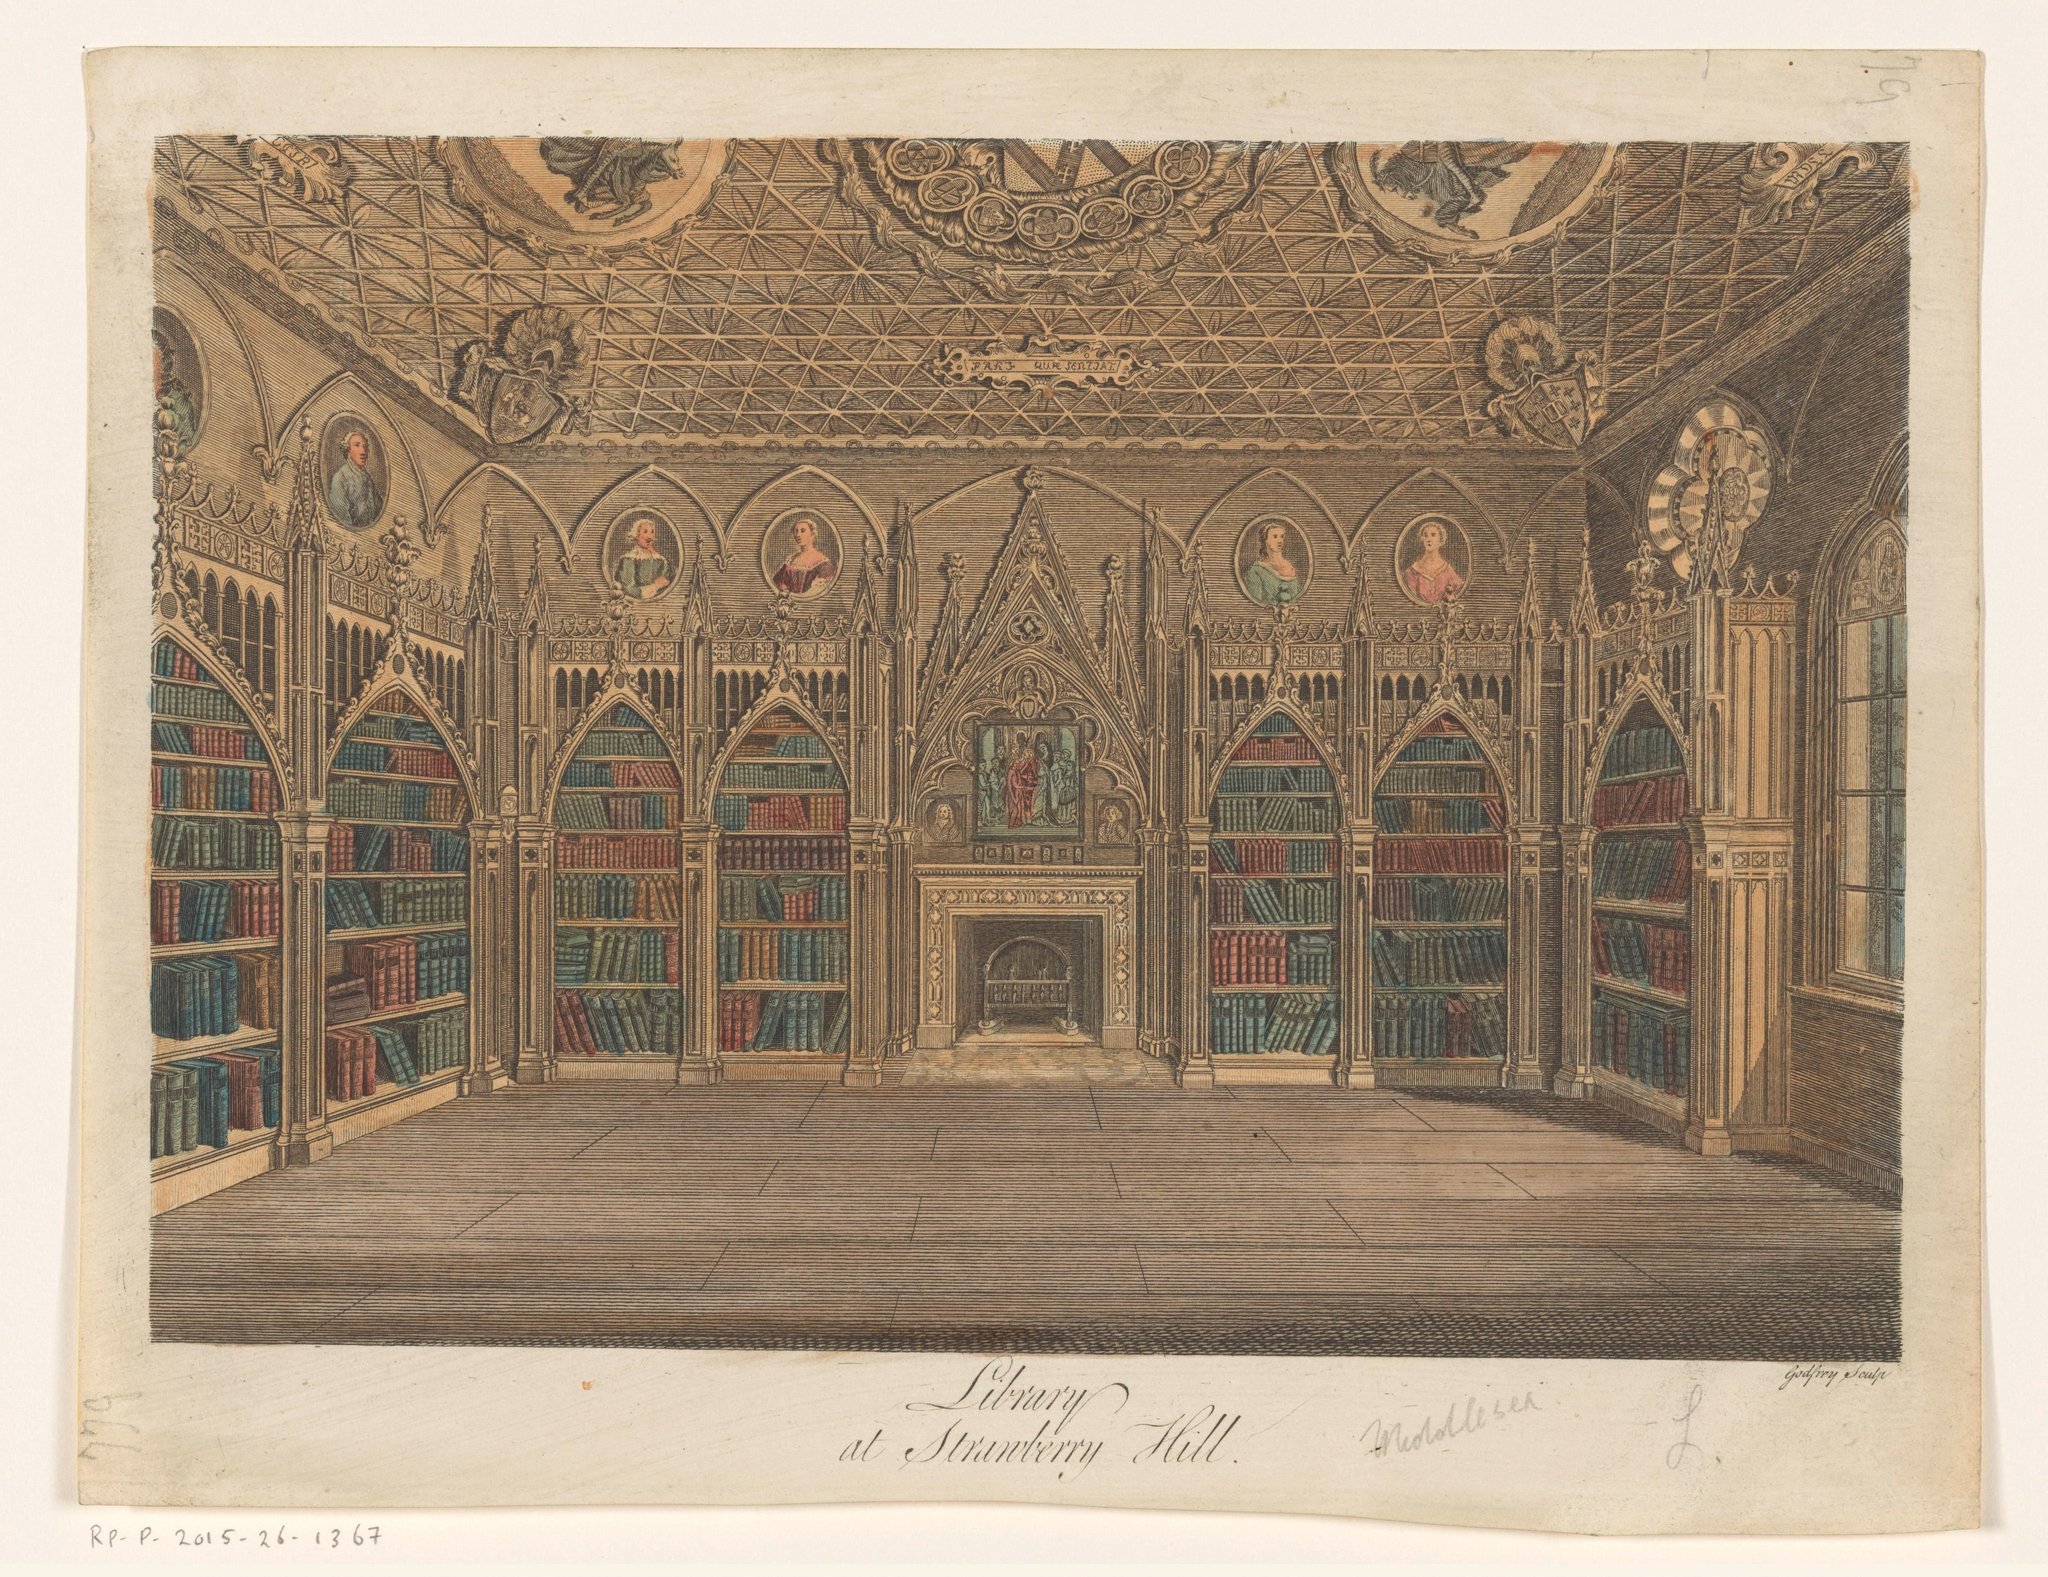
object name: book illustration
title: Bibliotheek van Strawberry Hill te Twickenham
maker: jean godefroy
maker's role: print maker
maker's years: 1771-1839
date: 1784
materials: paper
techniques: engraving, etching, hand coloring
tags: study; 'studiolo'; library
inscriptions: collector's mark: Lugt 2228, collector's mark: Lugt 4779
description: Prent afkomstig uit: A description of the villa of Mr. Horace Walpole, youngest son of Sir Robert Walpole Earl of Orford, at Strawberry-Hill near Twickenham, Middlesex : with an inventory of the furniture, pictures, curiosities, &c. Strawberry-Hill: gedrukt door Thomas Kirgate, 1784, tussen p. 32-33.